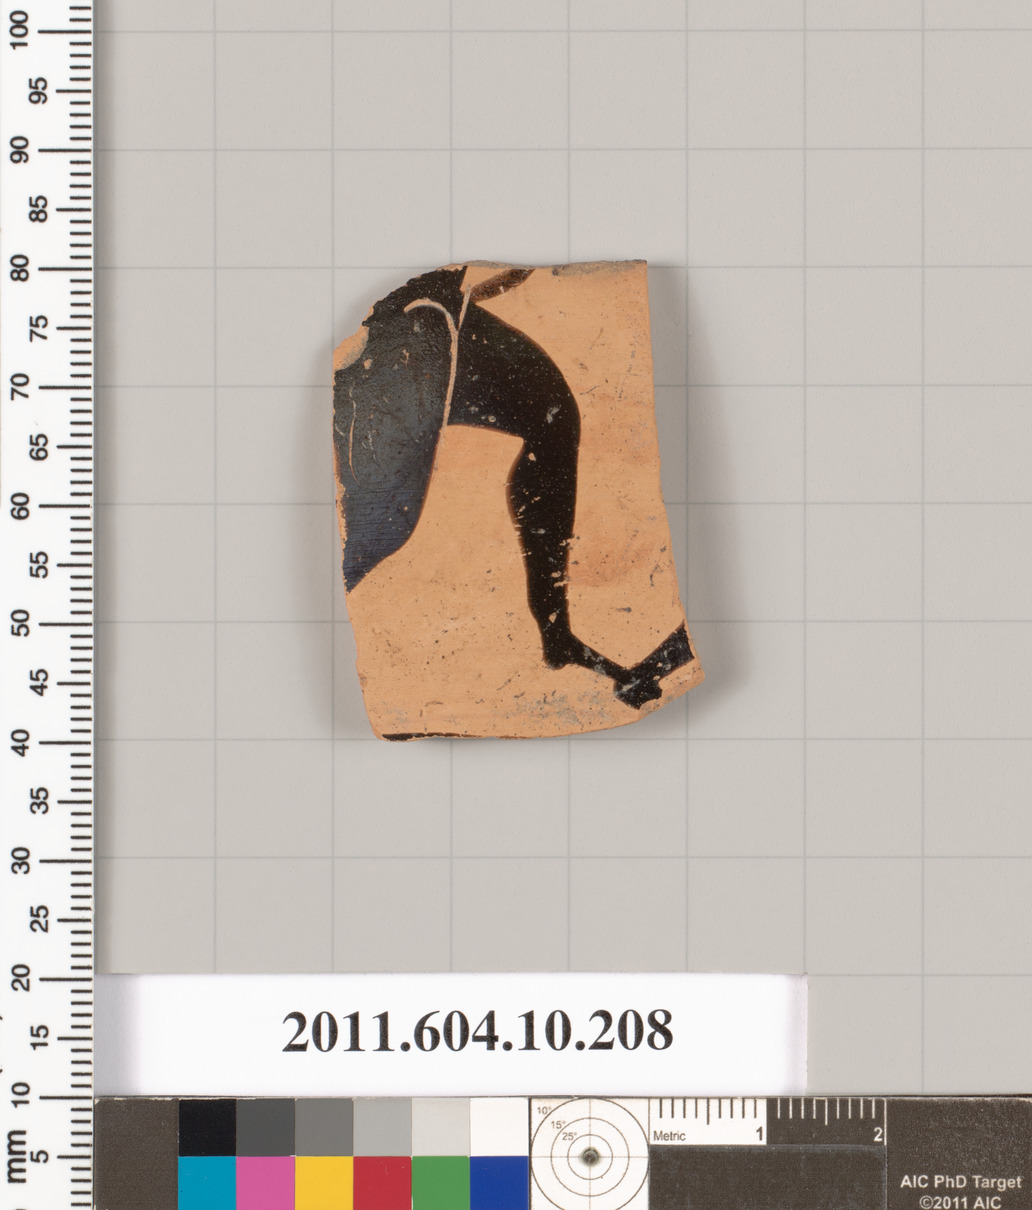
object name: amphora fragment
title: Terracotta fragment of an amphora (jar)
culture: etruscan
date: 600-501 BCE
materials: terracotta